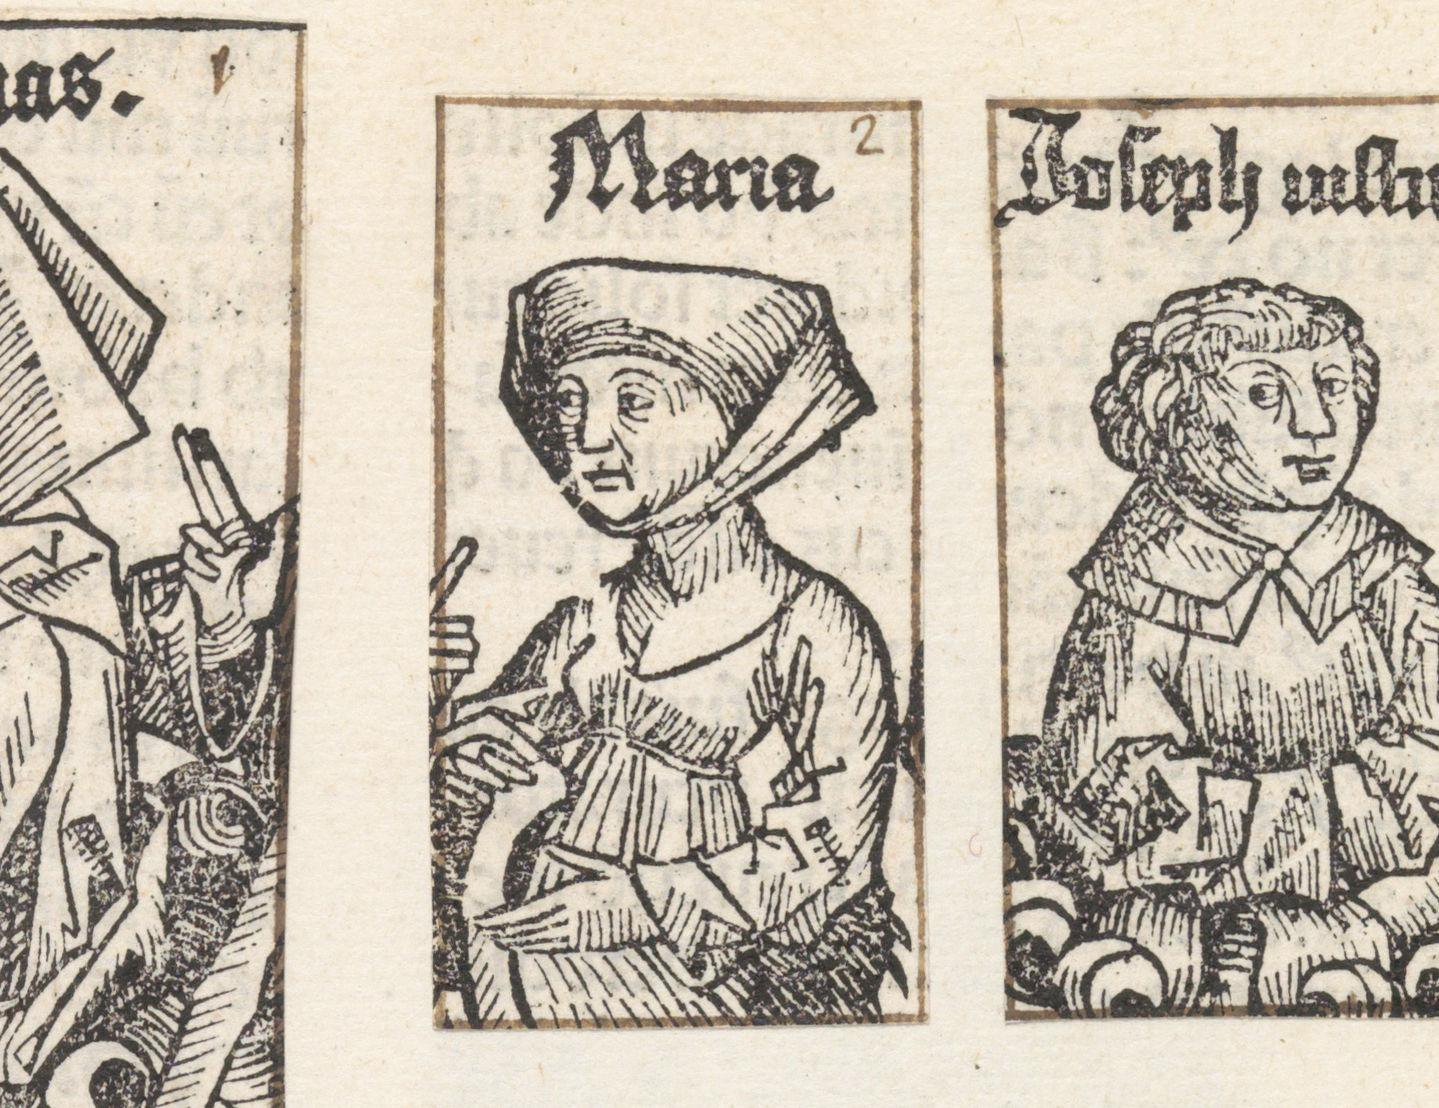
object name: book illustration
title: Maria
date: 1493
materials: paper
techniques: letterpress printing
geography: nuremberg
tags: mary kleophas, sister of the virgin mary, mother of james the less ('maria jacobi'); possible attributes: jar of ointment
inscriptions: inscription: ‘2’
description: De houtsnede wordt herhaaldelijk gebruikt als boekillustratie in de Liber Chronicarum (of Neurenbergkroniek) van Hartmann Schedel, verschenen in het Latijn en Duits in 1493. Zie de Latijnse uitgave, folio 95r.